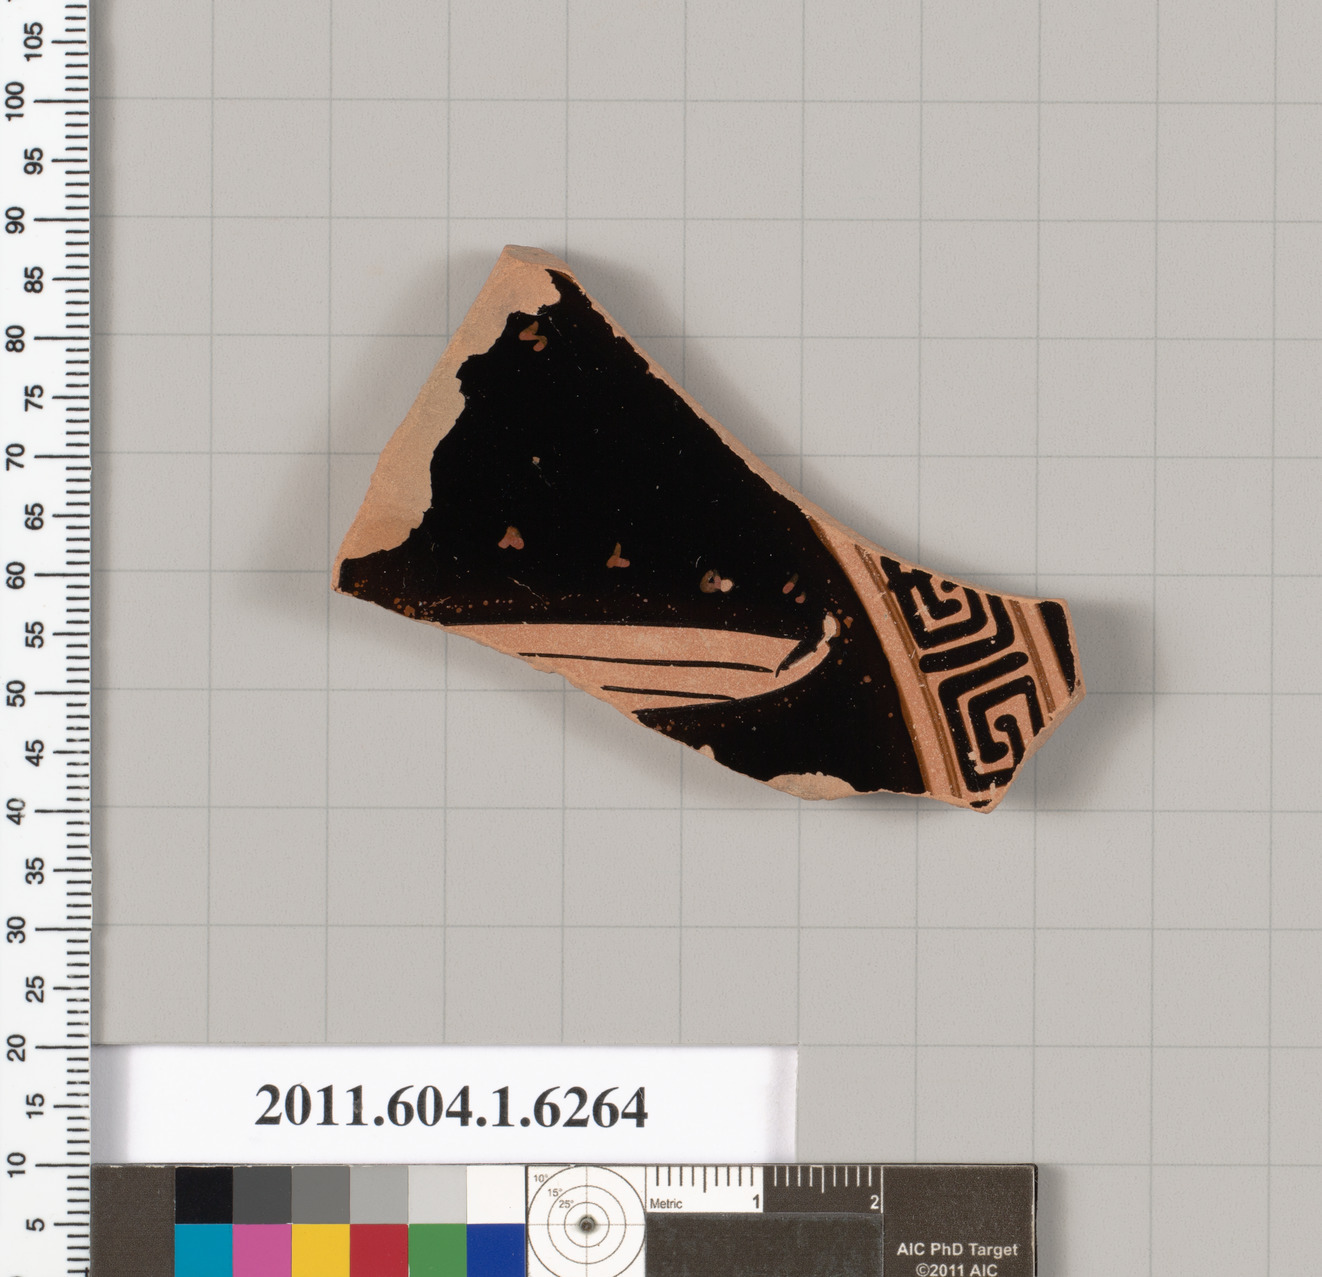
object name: kylix fragment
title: Terracotta fragment of a kylix (drinking cup)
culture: greek, attic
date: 500-480 BCE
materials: terracotta